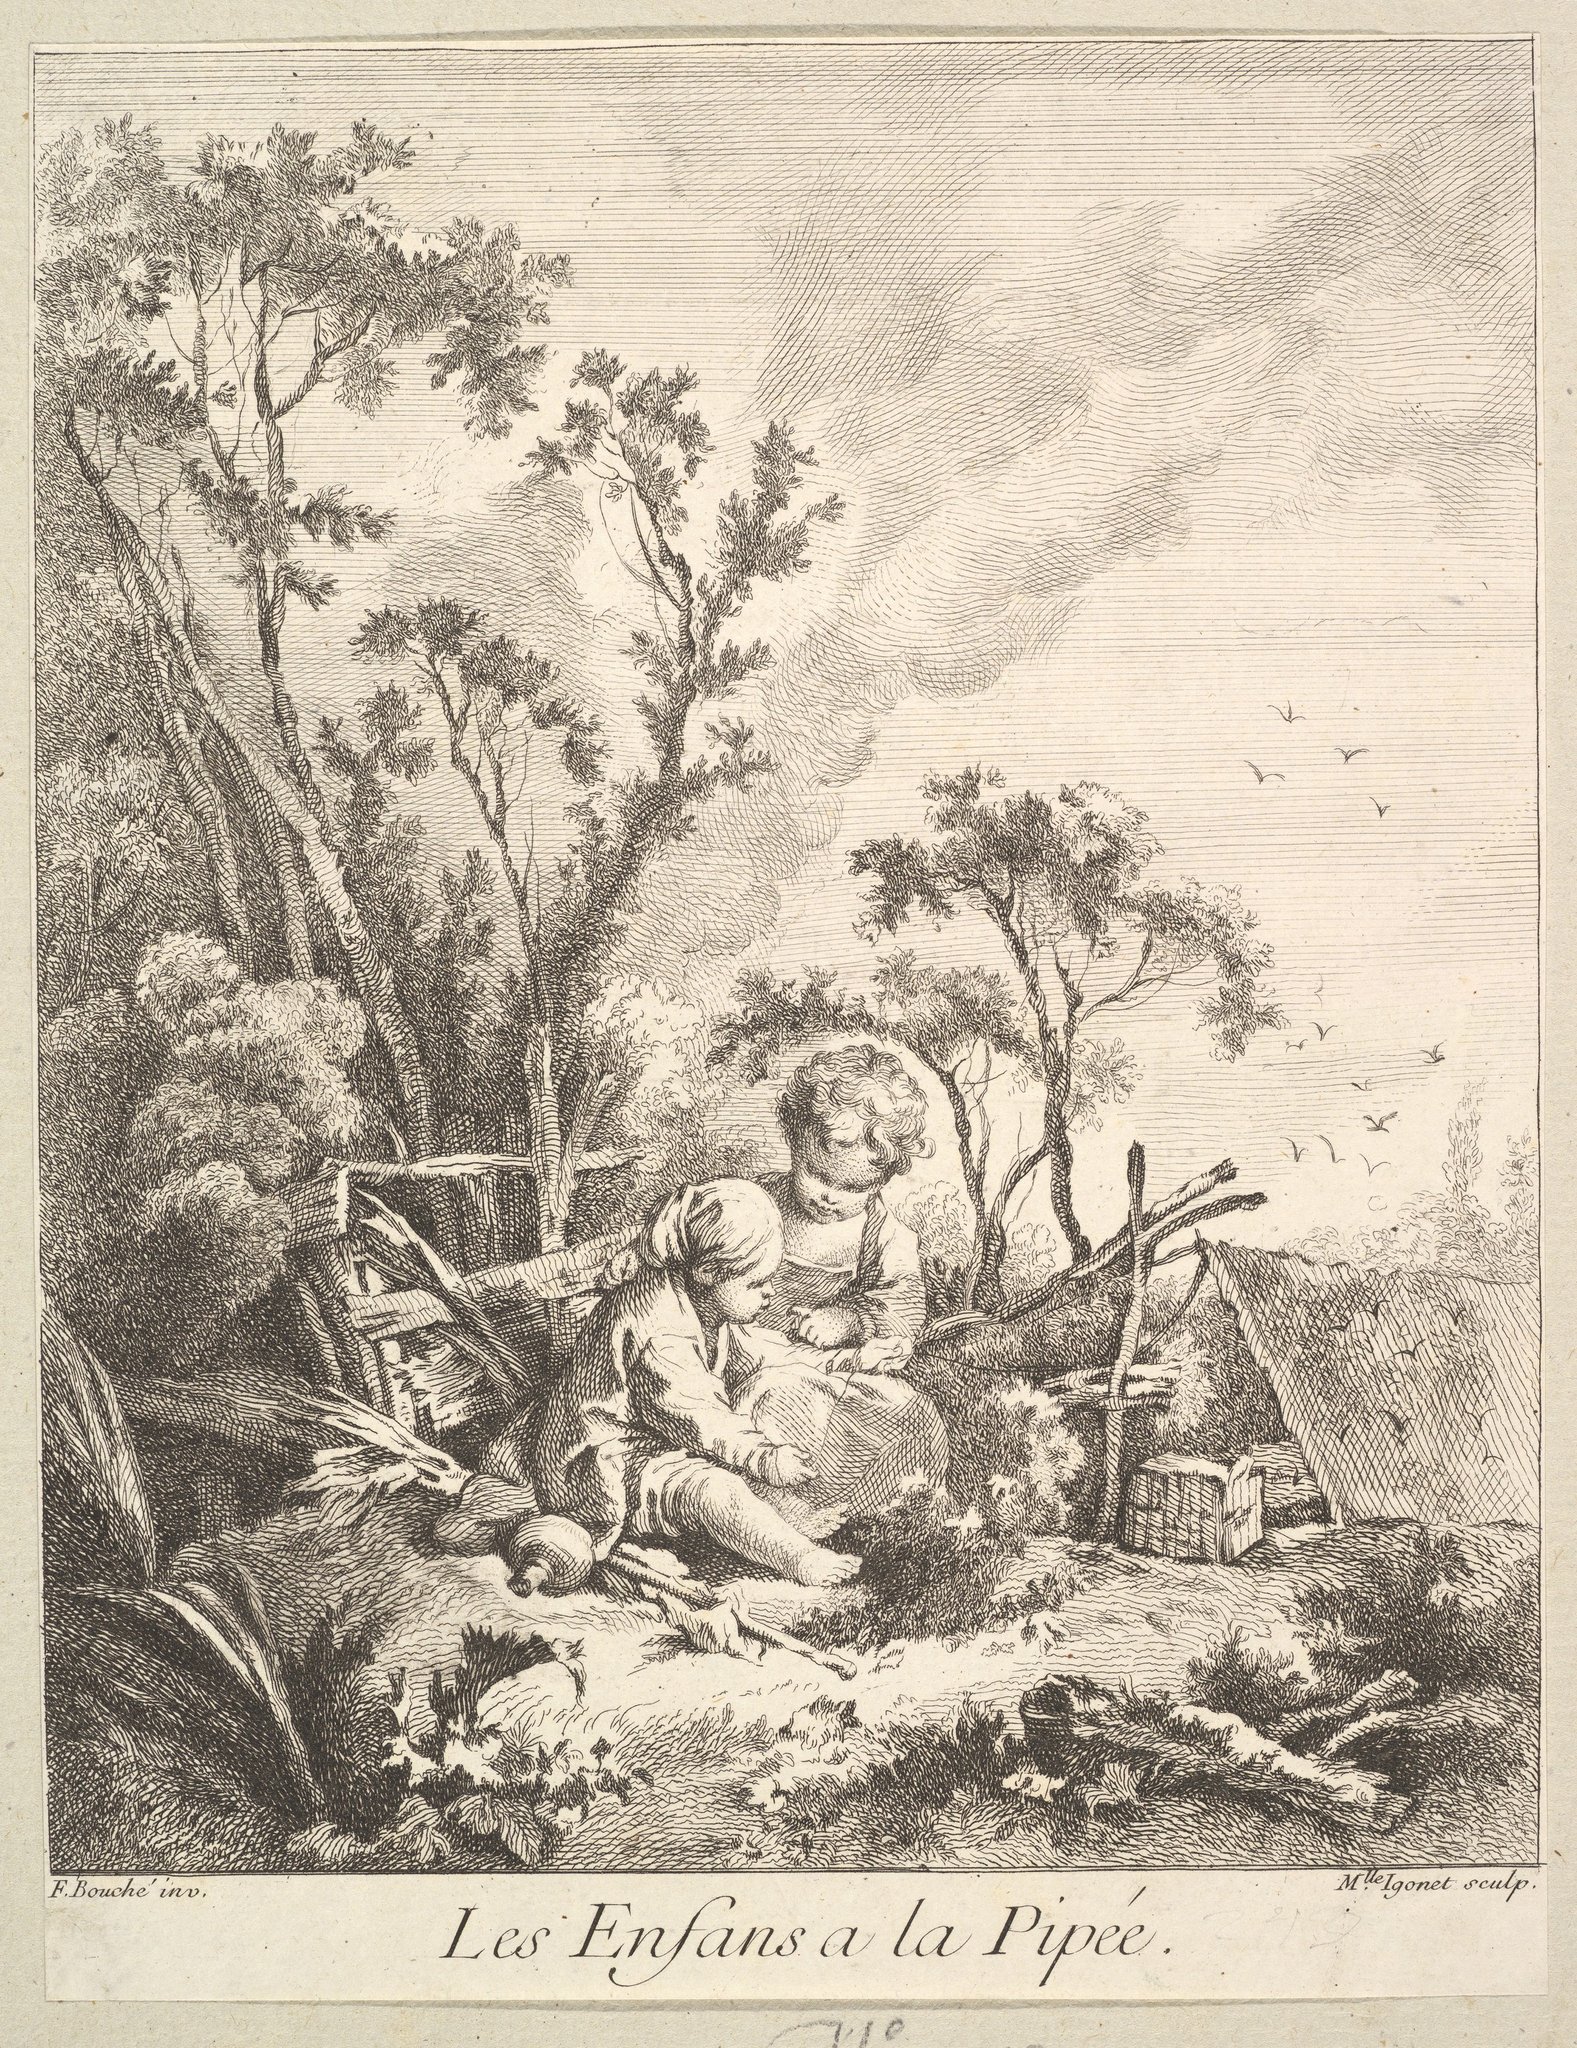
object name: print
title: Children Catching Birds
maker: marie madeleine igonet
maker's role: artist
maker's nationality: french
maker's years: 1744-1760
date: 1744-1760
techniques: engraving, etching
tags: birds,children